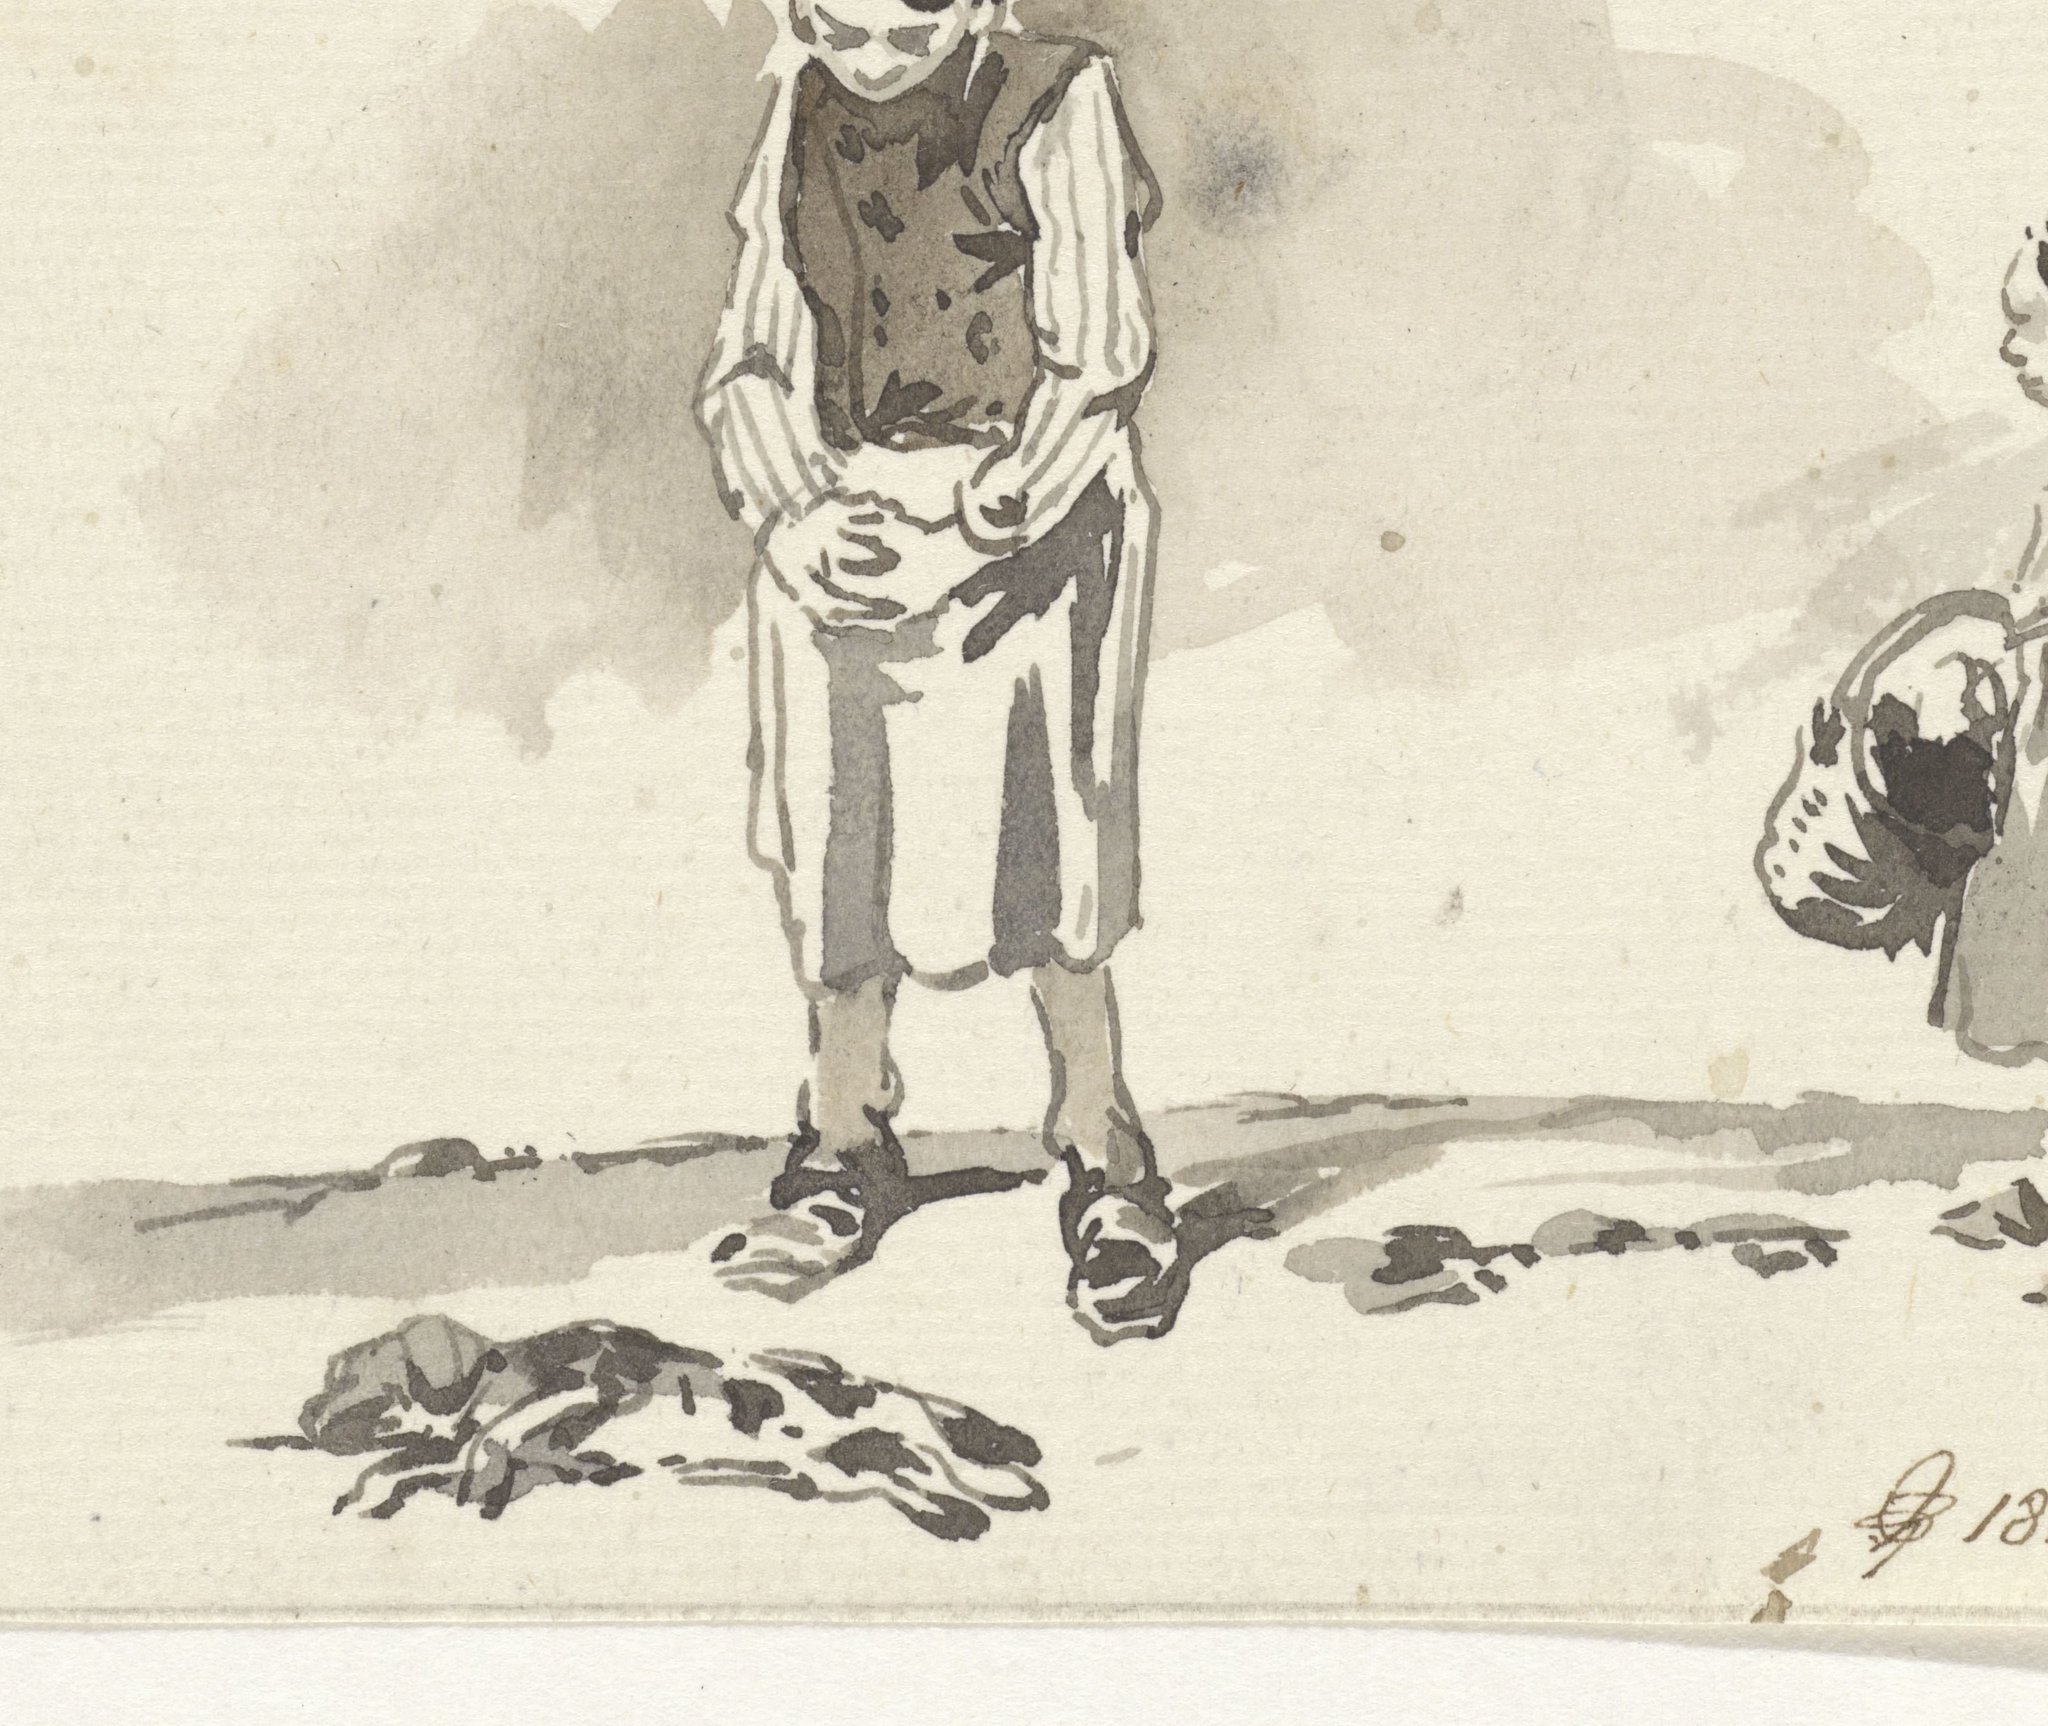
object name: drawing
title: Jongen en meisje rouwend bij lichaam van een hond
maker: pieter van loon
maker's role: draughtsman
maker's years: 1801-1873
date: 1842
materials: ink, paper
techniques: brush, pen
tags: friendship between man and animal; caressing, petting, dog